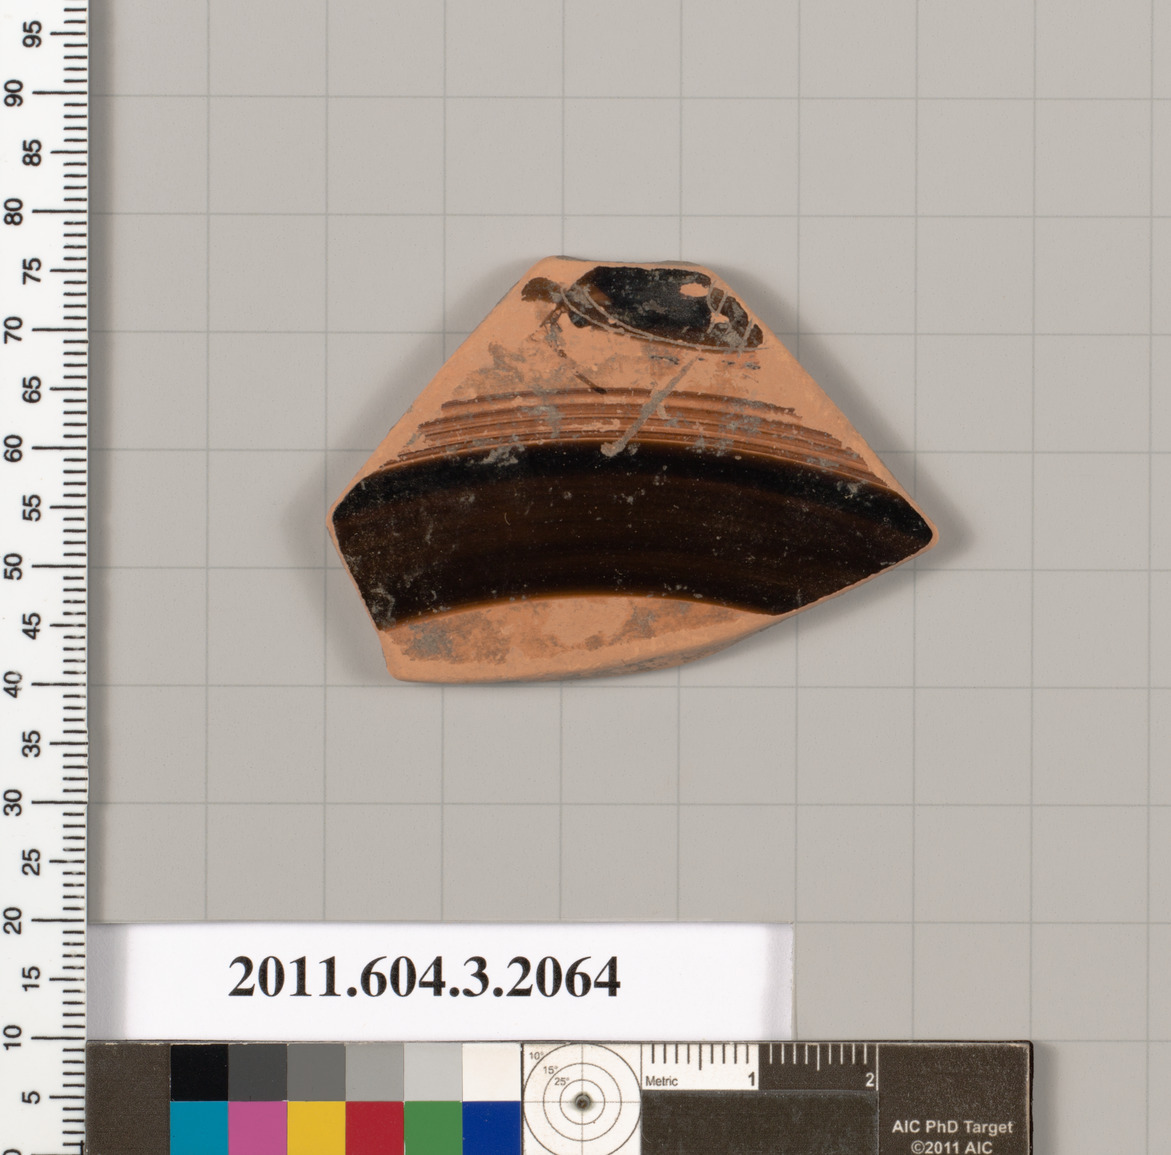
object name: kylix fragment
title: Terracotta fragment of a kylix (drinking cup)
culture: greek, attic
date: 534-501 BCE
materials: terracotta